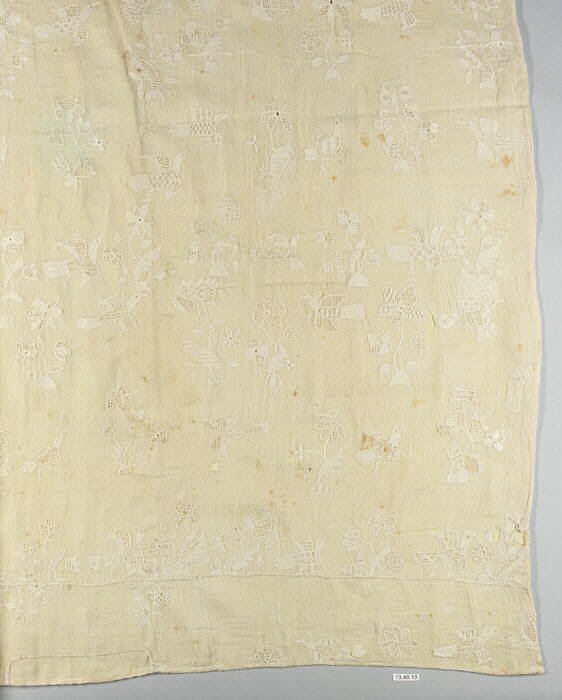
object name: panel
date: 1701-1733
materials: cotton, linen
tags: birds,flowers